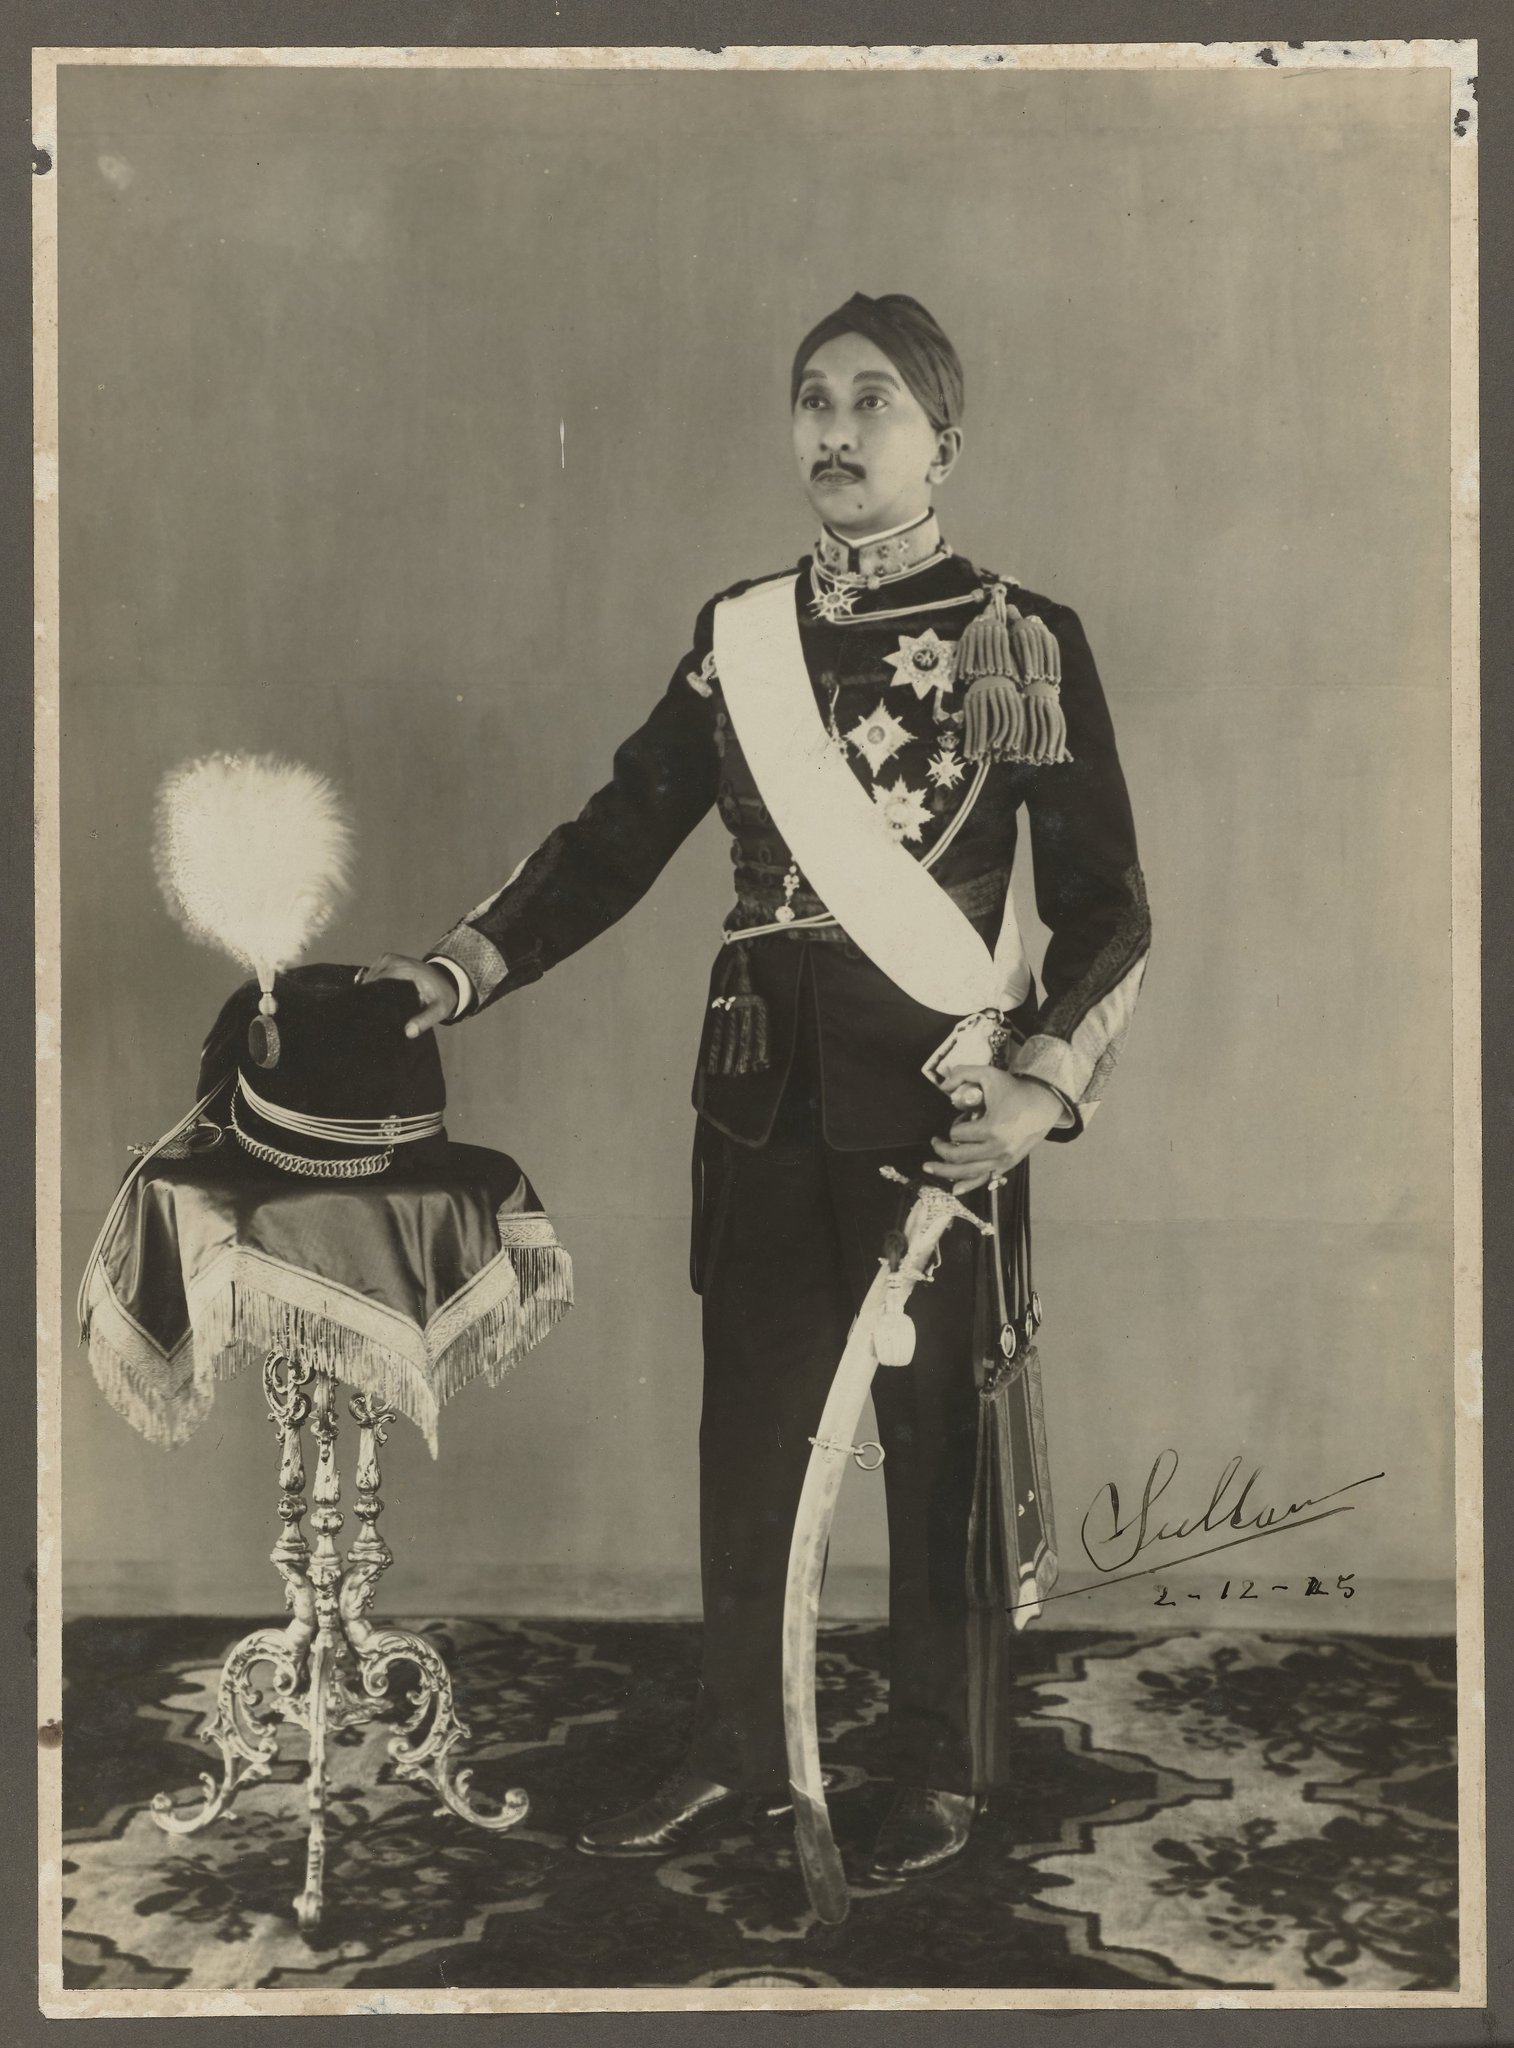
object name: photograph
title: Hamengkoe Boewono VIII (1861-1939), sultan van Jokjakarta (1921-1939)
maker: Anonymous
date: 1925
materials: photographic support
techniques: photography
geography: dutch east indies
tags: historical persons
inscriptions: signature and date: ‘Sultan 2-12-25’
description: Staatsieportret van de sultan van Jokjakarta, Hamengkoe Boewono VIII. Het portret is ondertekend met 'Sultan 2-12-25'.